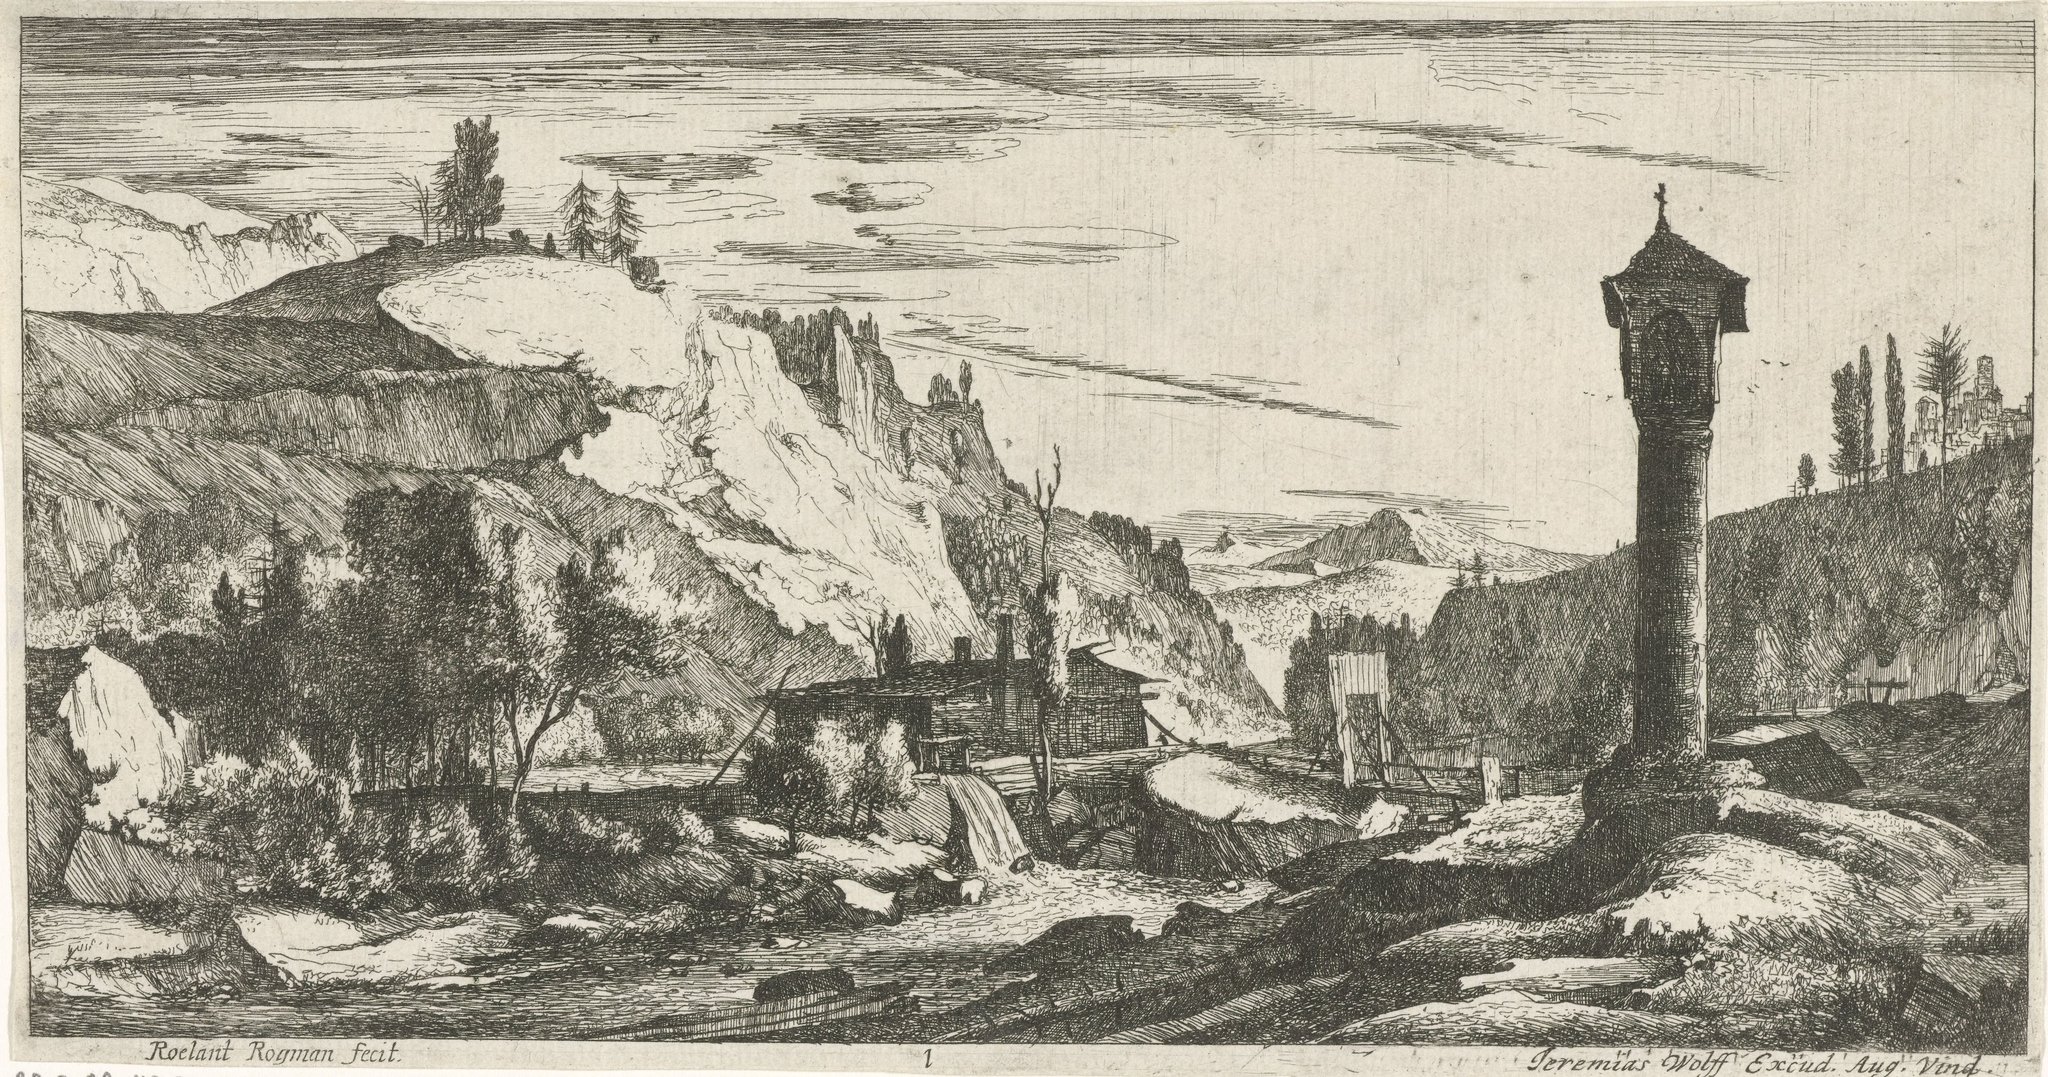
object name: print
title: Tiroolse landschappen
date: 1673-1724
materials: paper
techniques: etching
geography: amsterdam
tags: column, pillar ~ architecture, landscape with bridge, viaduct or aqueduct, rural housing, e.g. country-house, villa, cottage, mountains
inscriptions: collector's mark: Lugt 2228a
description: Gezicht op een berglandschap in Tirol, met op de voorgrond een zuil met gedenkteken. Temidden van de bergen en rotsen een brug, die naar een hut bij een stroom leidt. Rechts op de achtergrond de contouren van een stad. Prent uit een serie van acht prenten met Tiroolse landschappen.